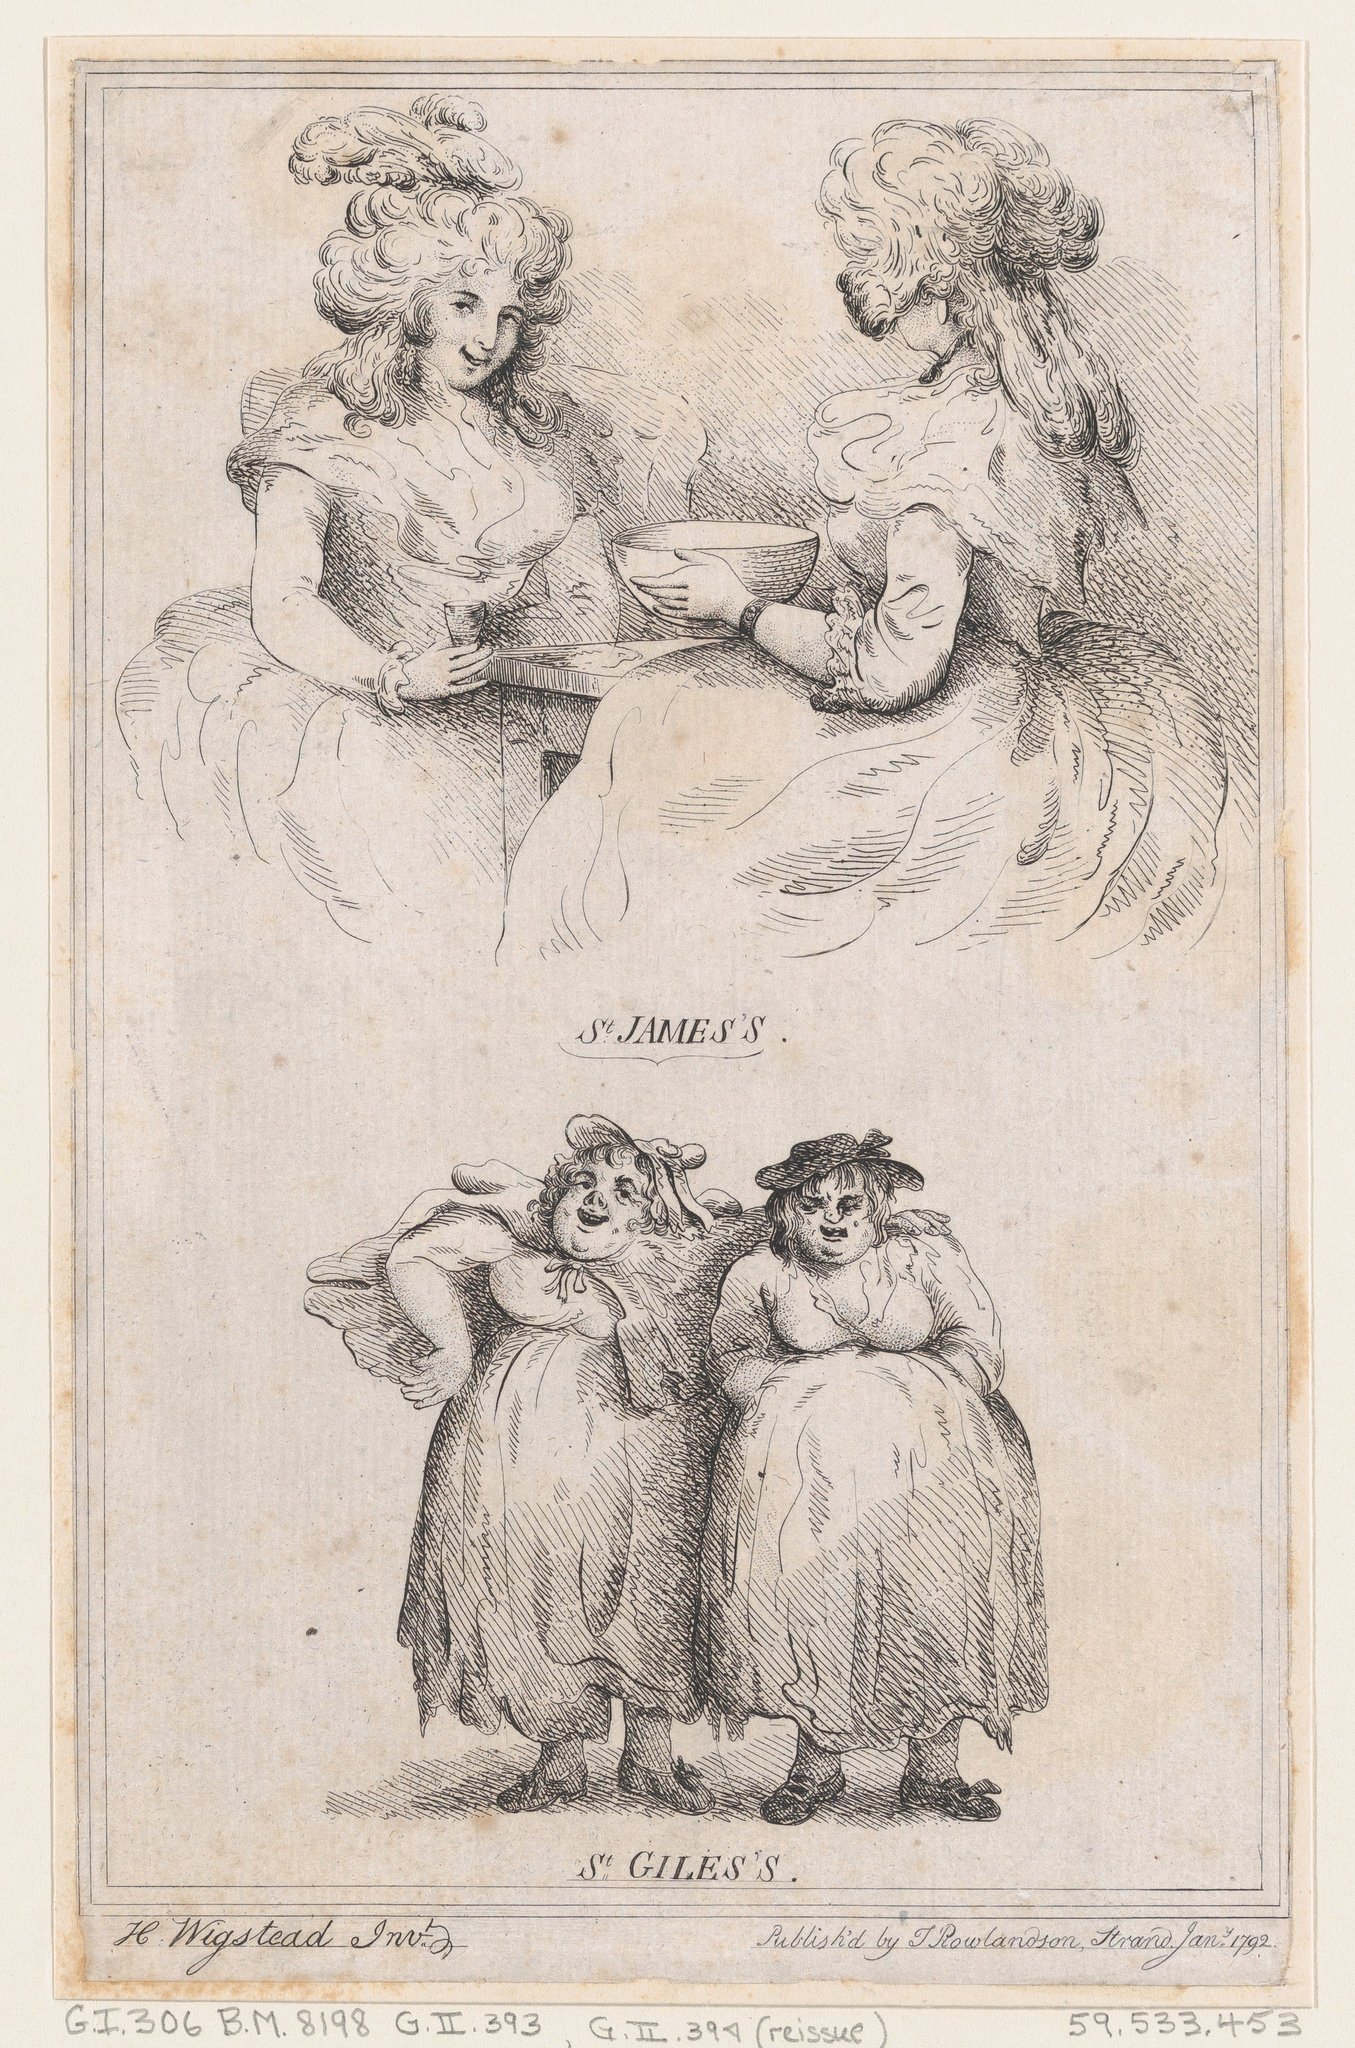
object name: print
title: St James's and St Giles's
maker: thomas rowlandson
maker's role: artist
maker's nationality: british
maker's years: 1757-1827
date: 1792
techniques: etching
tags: satire,women